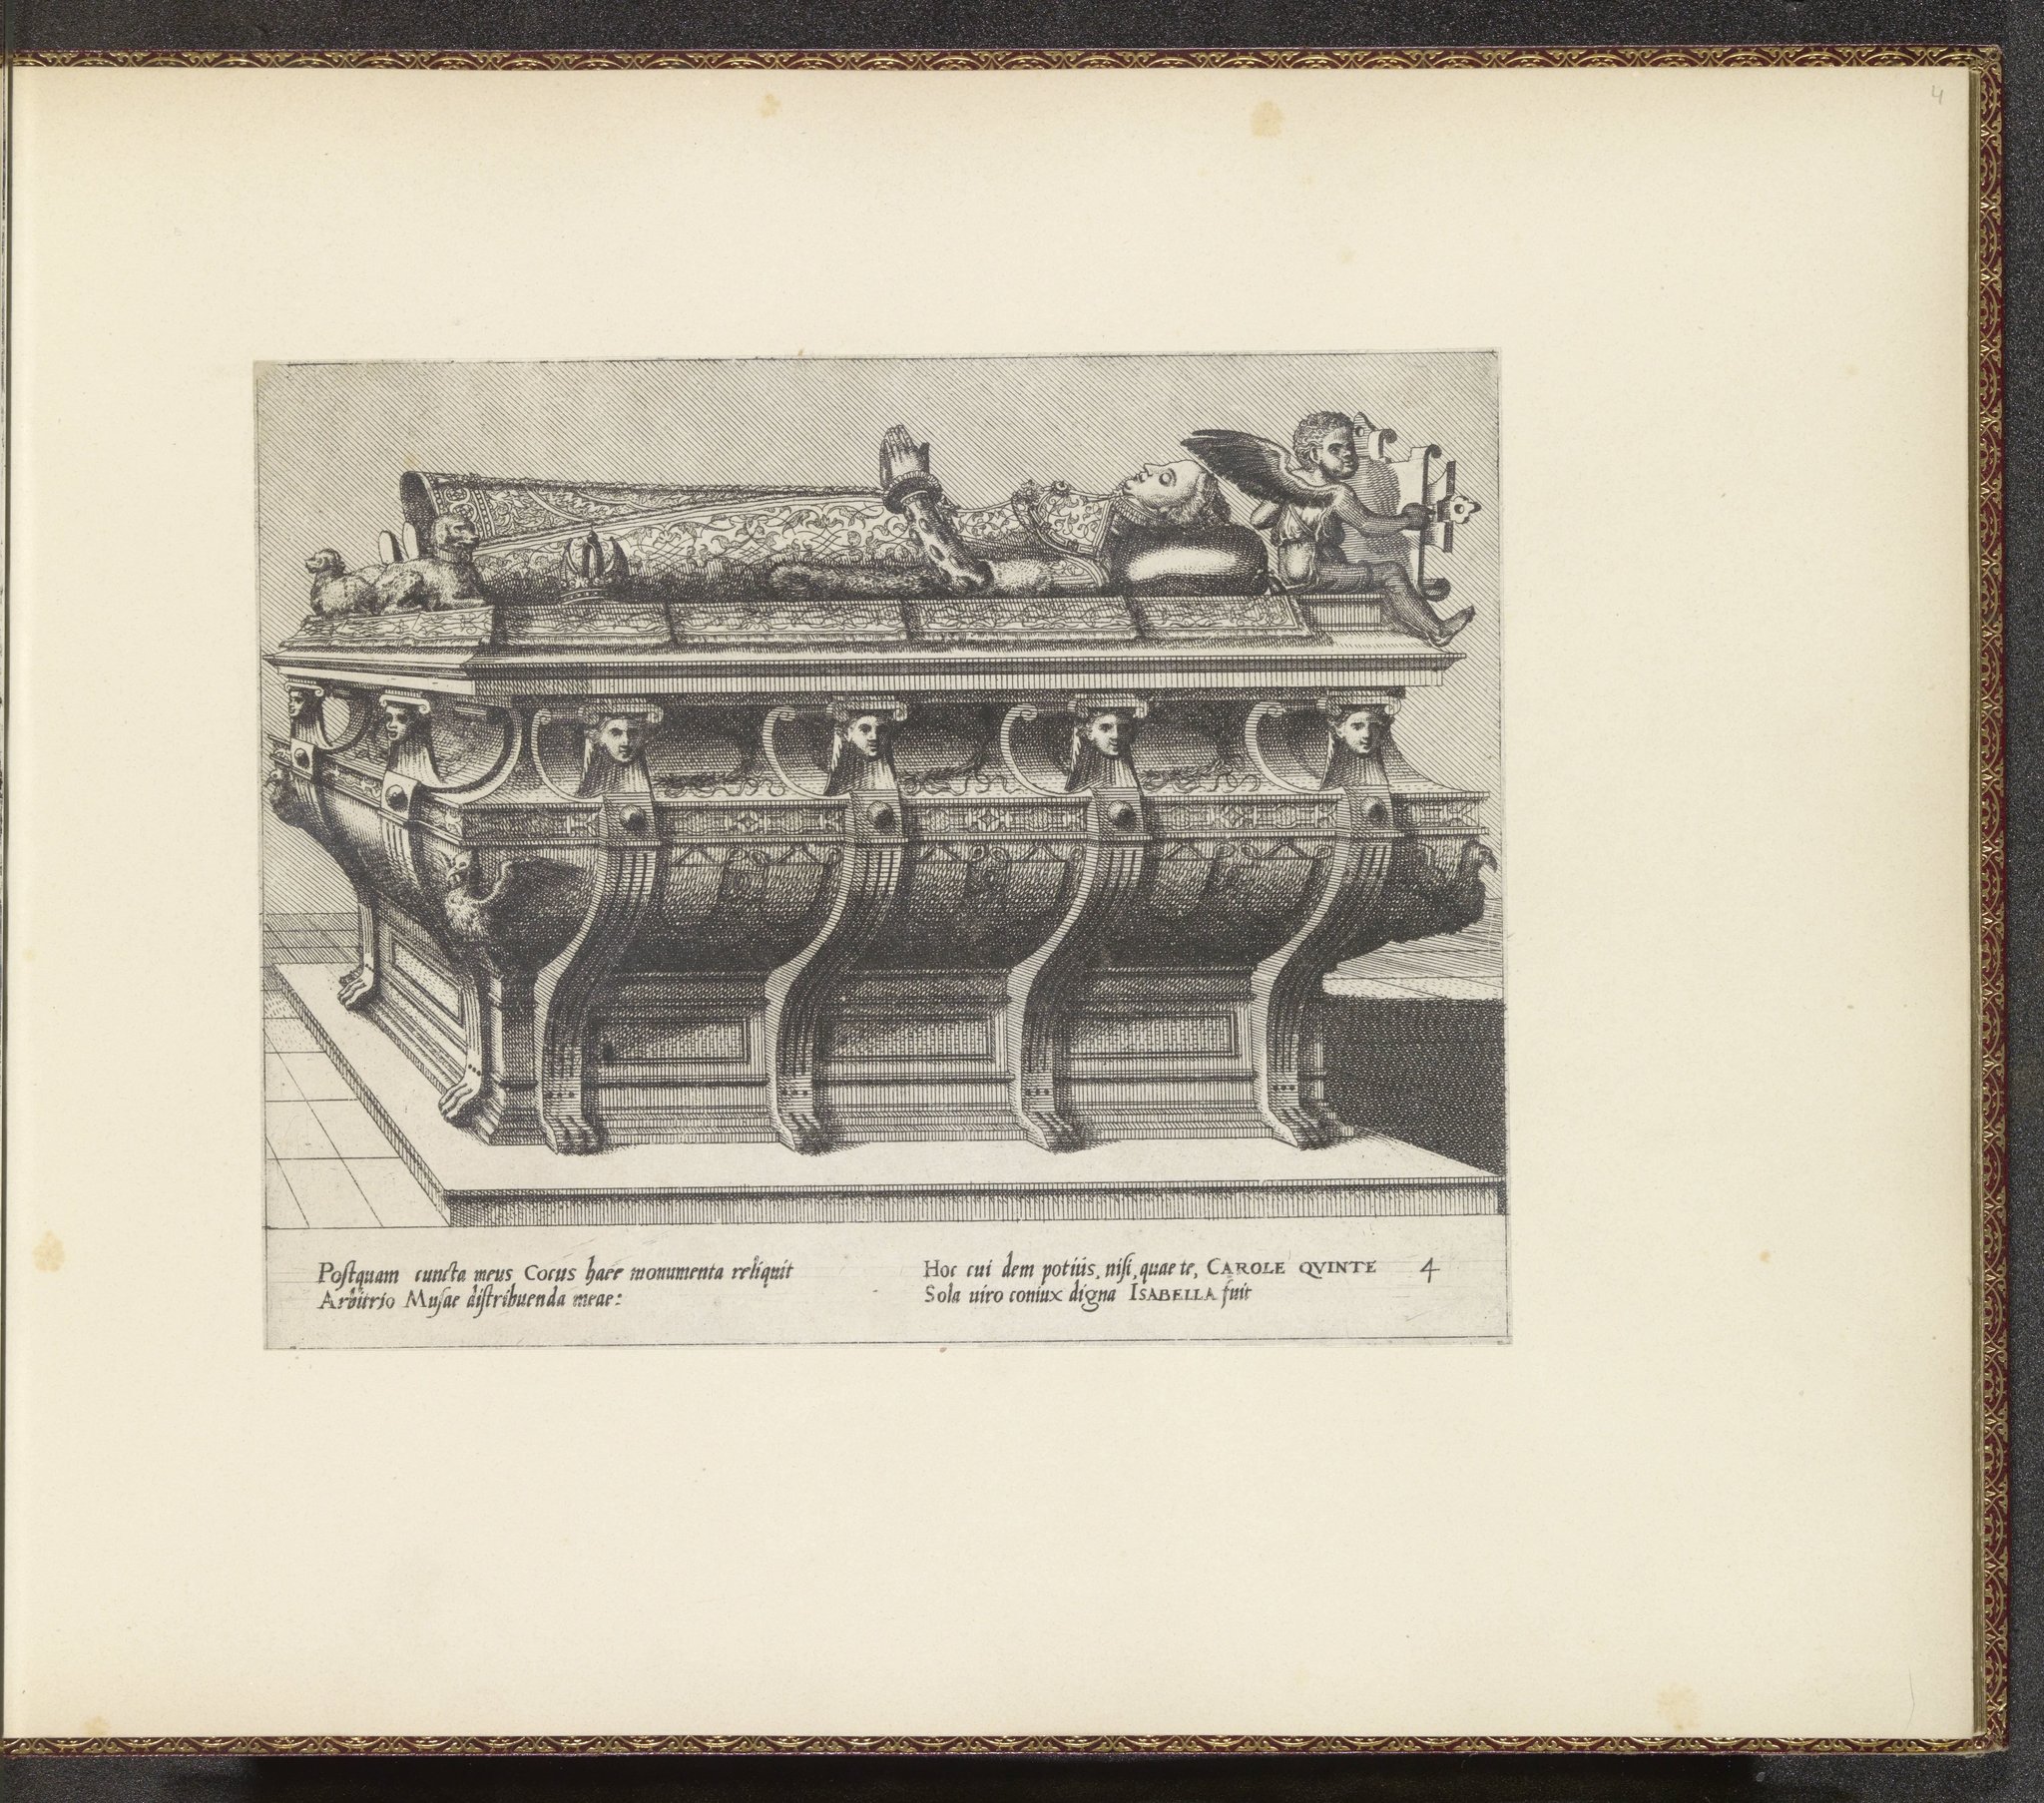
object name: ornament print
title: Tombes en grafmonumenten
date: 1563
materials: paper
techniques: etching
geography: antwerp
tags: effigy, 'gisant' (portrait-figure on closed coffin or in 'castrum doloris'), transi, grave-building, monumental tomb, grave, tomb and other grave-forms and grave-markers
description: Vrijstaand grafmonument voor Isabella. De tombe wordt gekenmerkt door de beeltenis van een liggende vrouw op de tombe (een gisant). Bij haar voeten liggen twee honden en een kroon. Aan het hoofdeind zit een engel met een cartouche in een omlijsting van rolwerk. In de ondermarge vier regels tekst, in twee kolommen, in het Latijn. De prent maakt deel uit van een album.